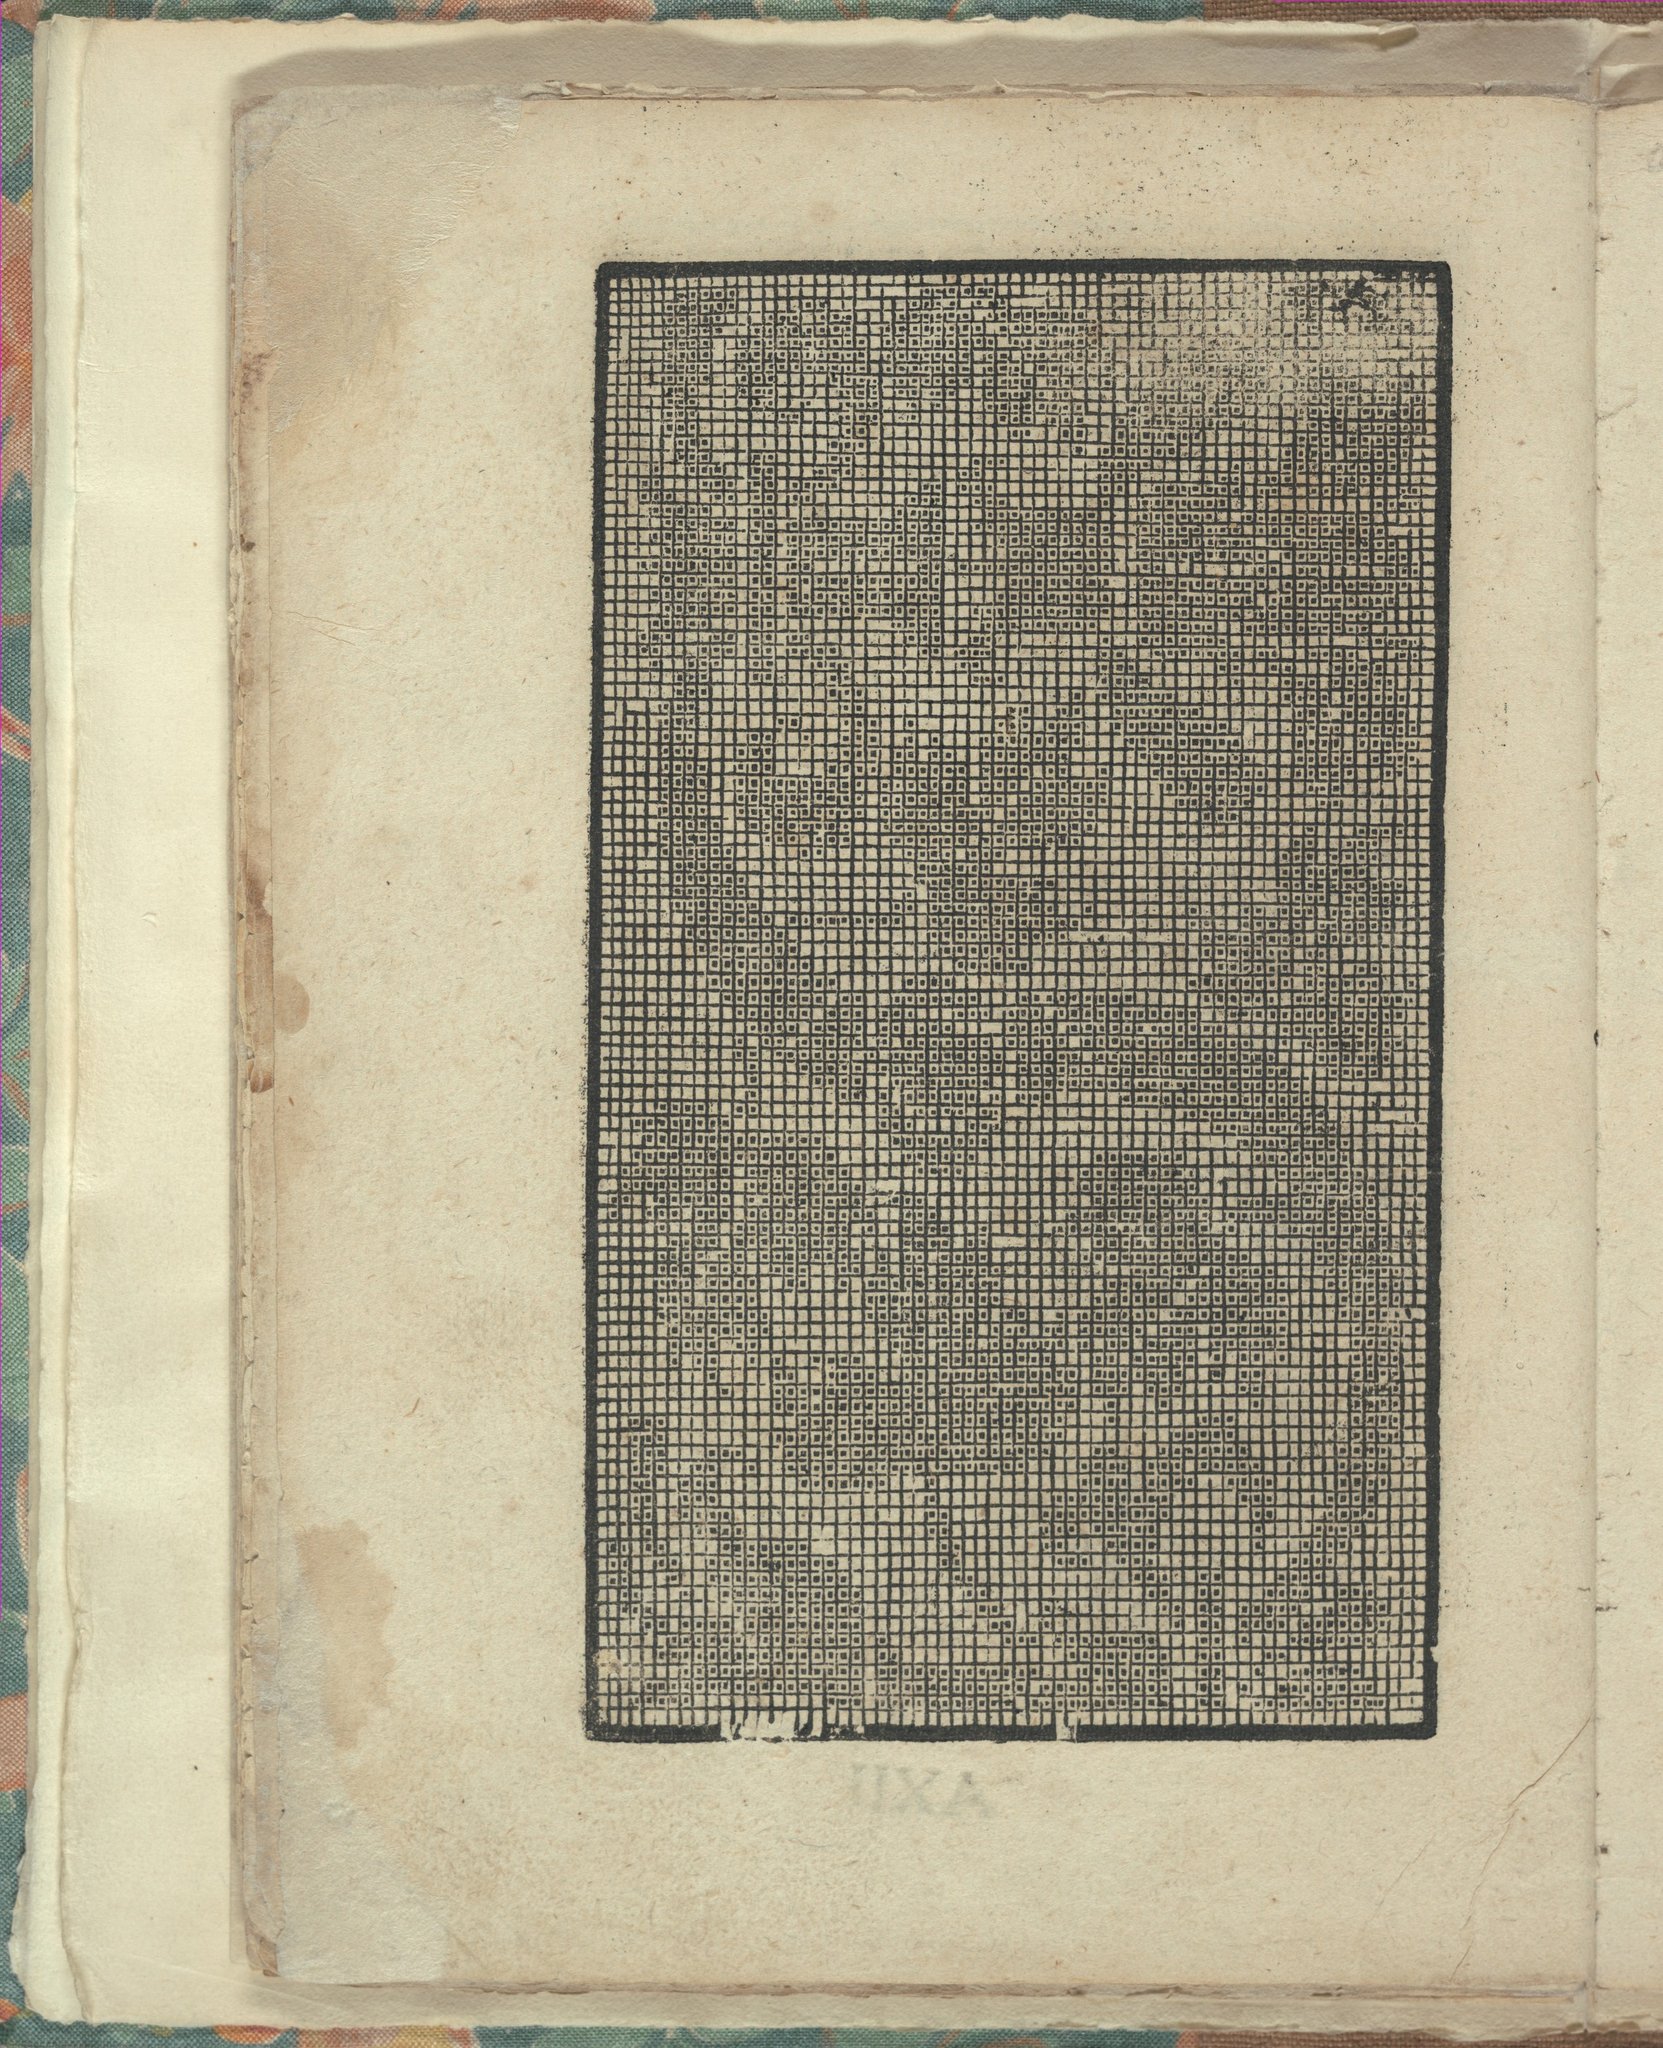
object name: book print ornament architecture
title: Opera Nova Universali intitulata Corona di racammi, page 27 (verso)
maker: giovanni andrea vavassore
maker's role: publisher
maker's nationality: italian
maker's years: 1530-1573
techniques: woodcut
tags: flowers